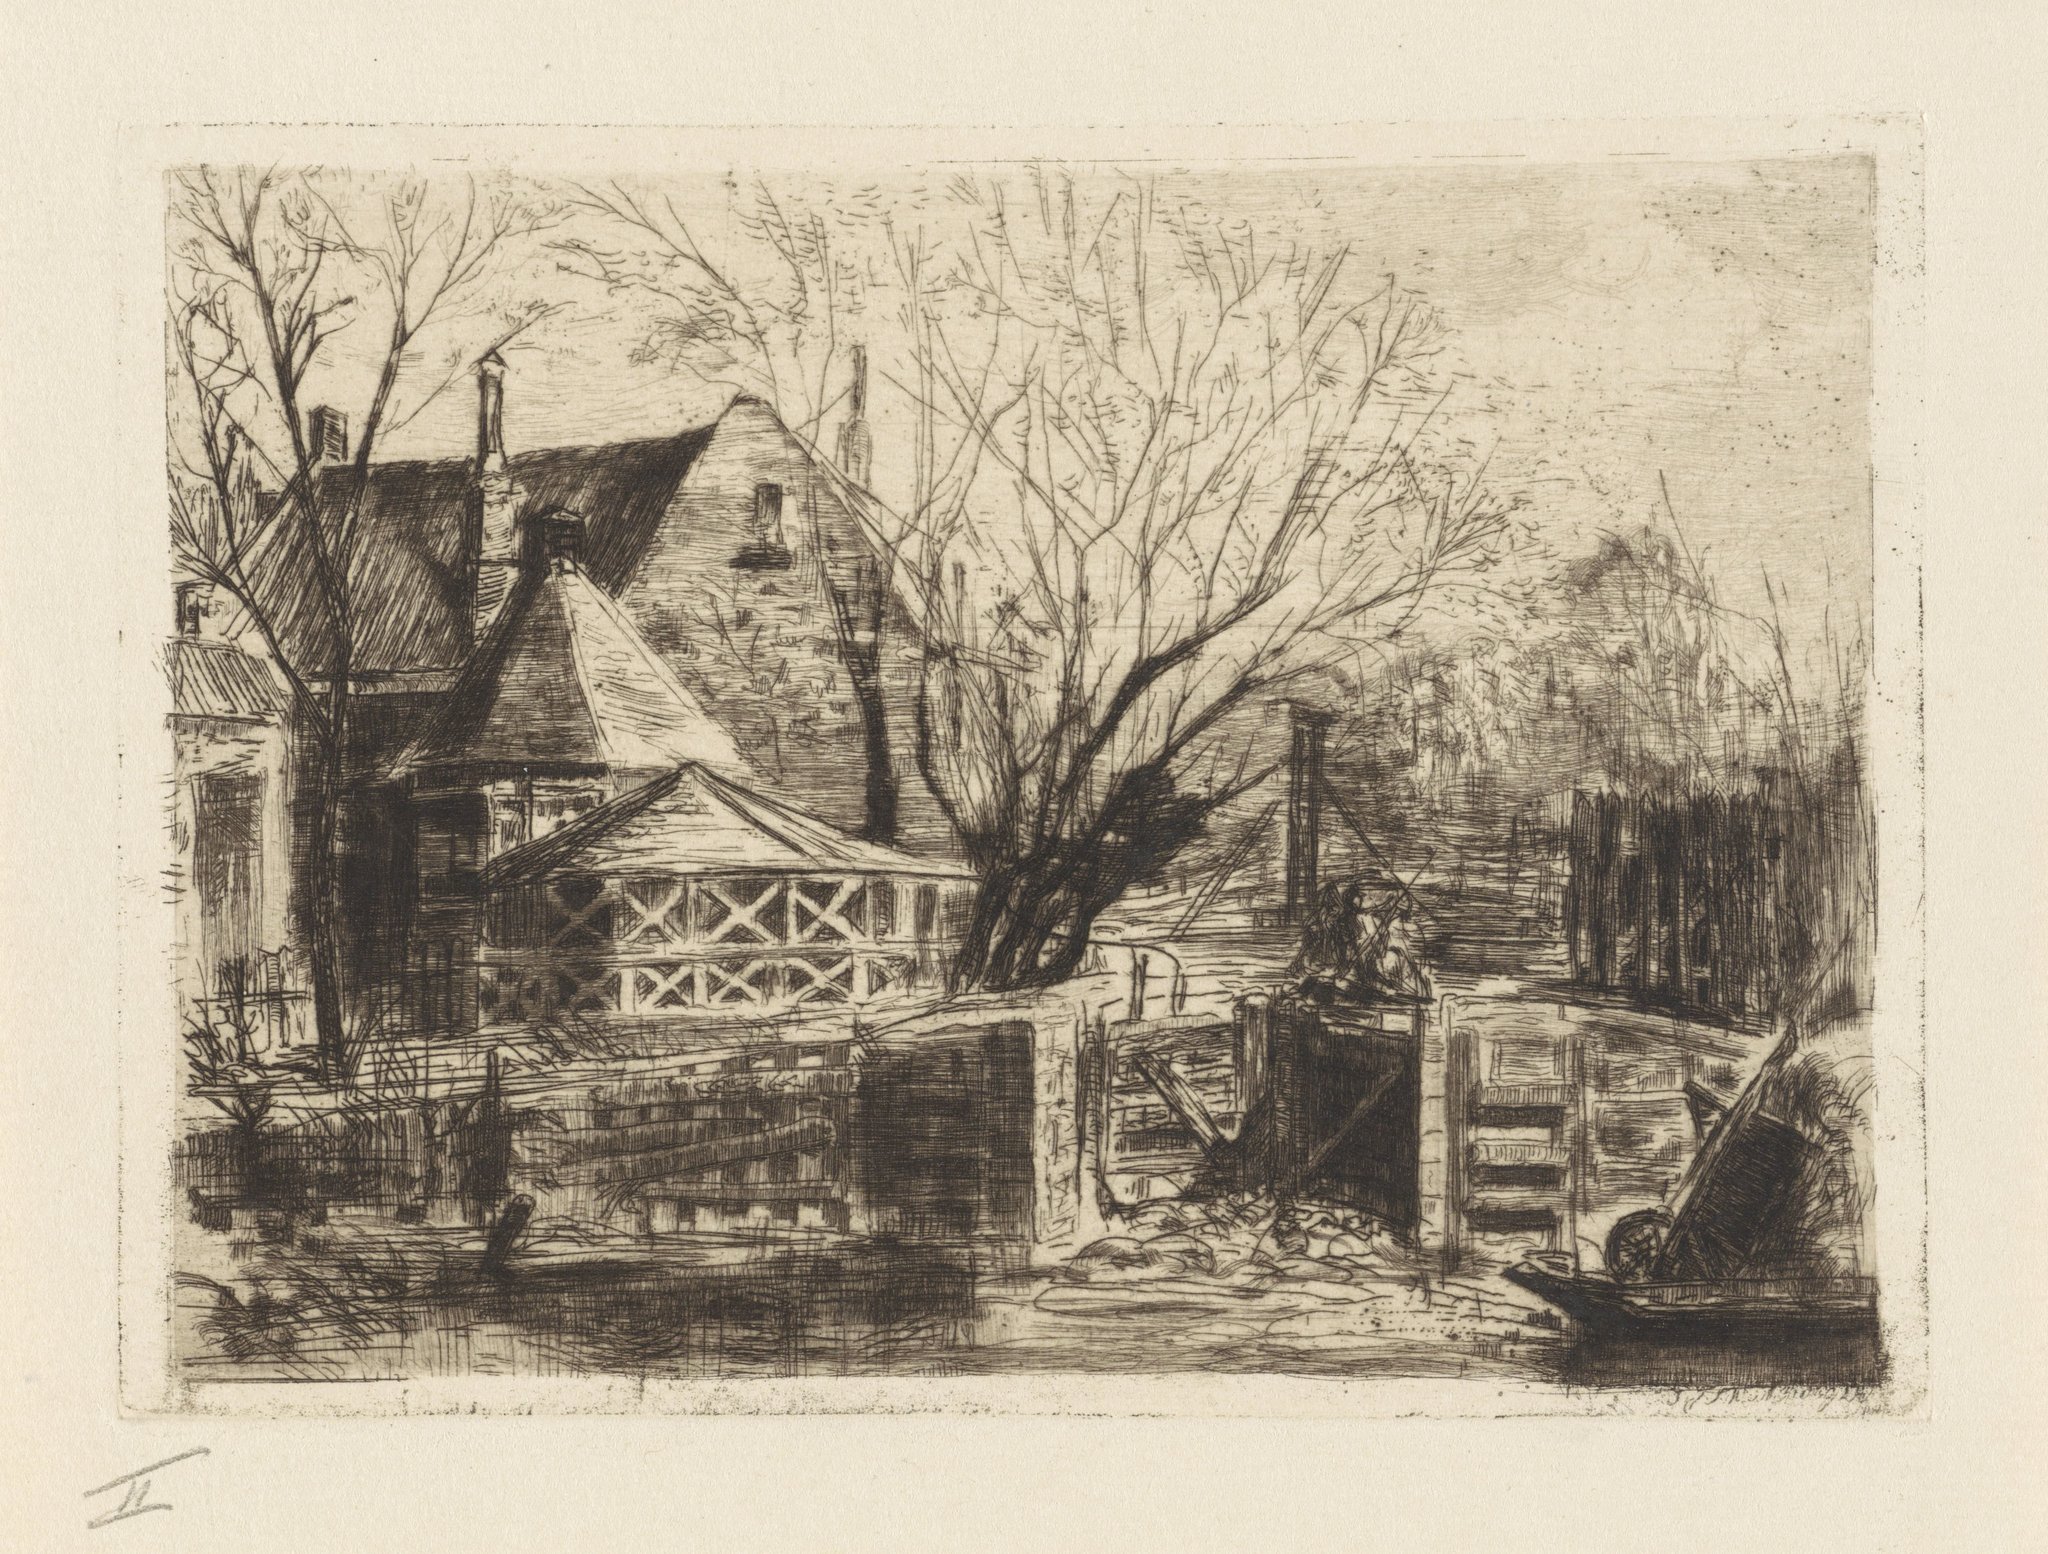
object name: print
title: Polderhuis met de sluis in Boerenwetering te Amsterdam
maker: frans schikkinger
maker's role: print maker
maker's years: 1838-1902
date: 1848-1902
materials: paper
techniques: drypoint, etching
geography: amsterdam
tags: farm (building)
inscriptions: collector's mark: Lugt 2228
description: Polderhuis met de sluis in Boerenwetering te Amsterdam, gezien naar de Weteringschans.